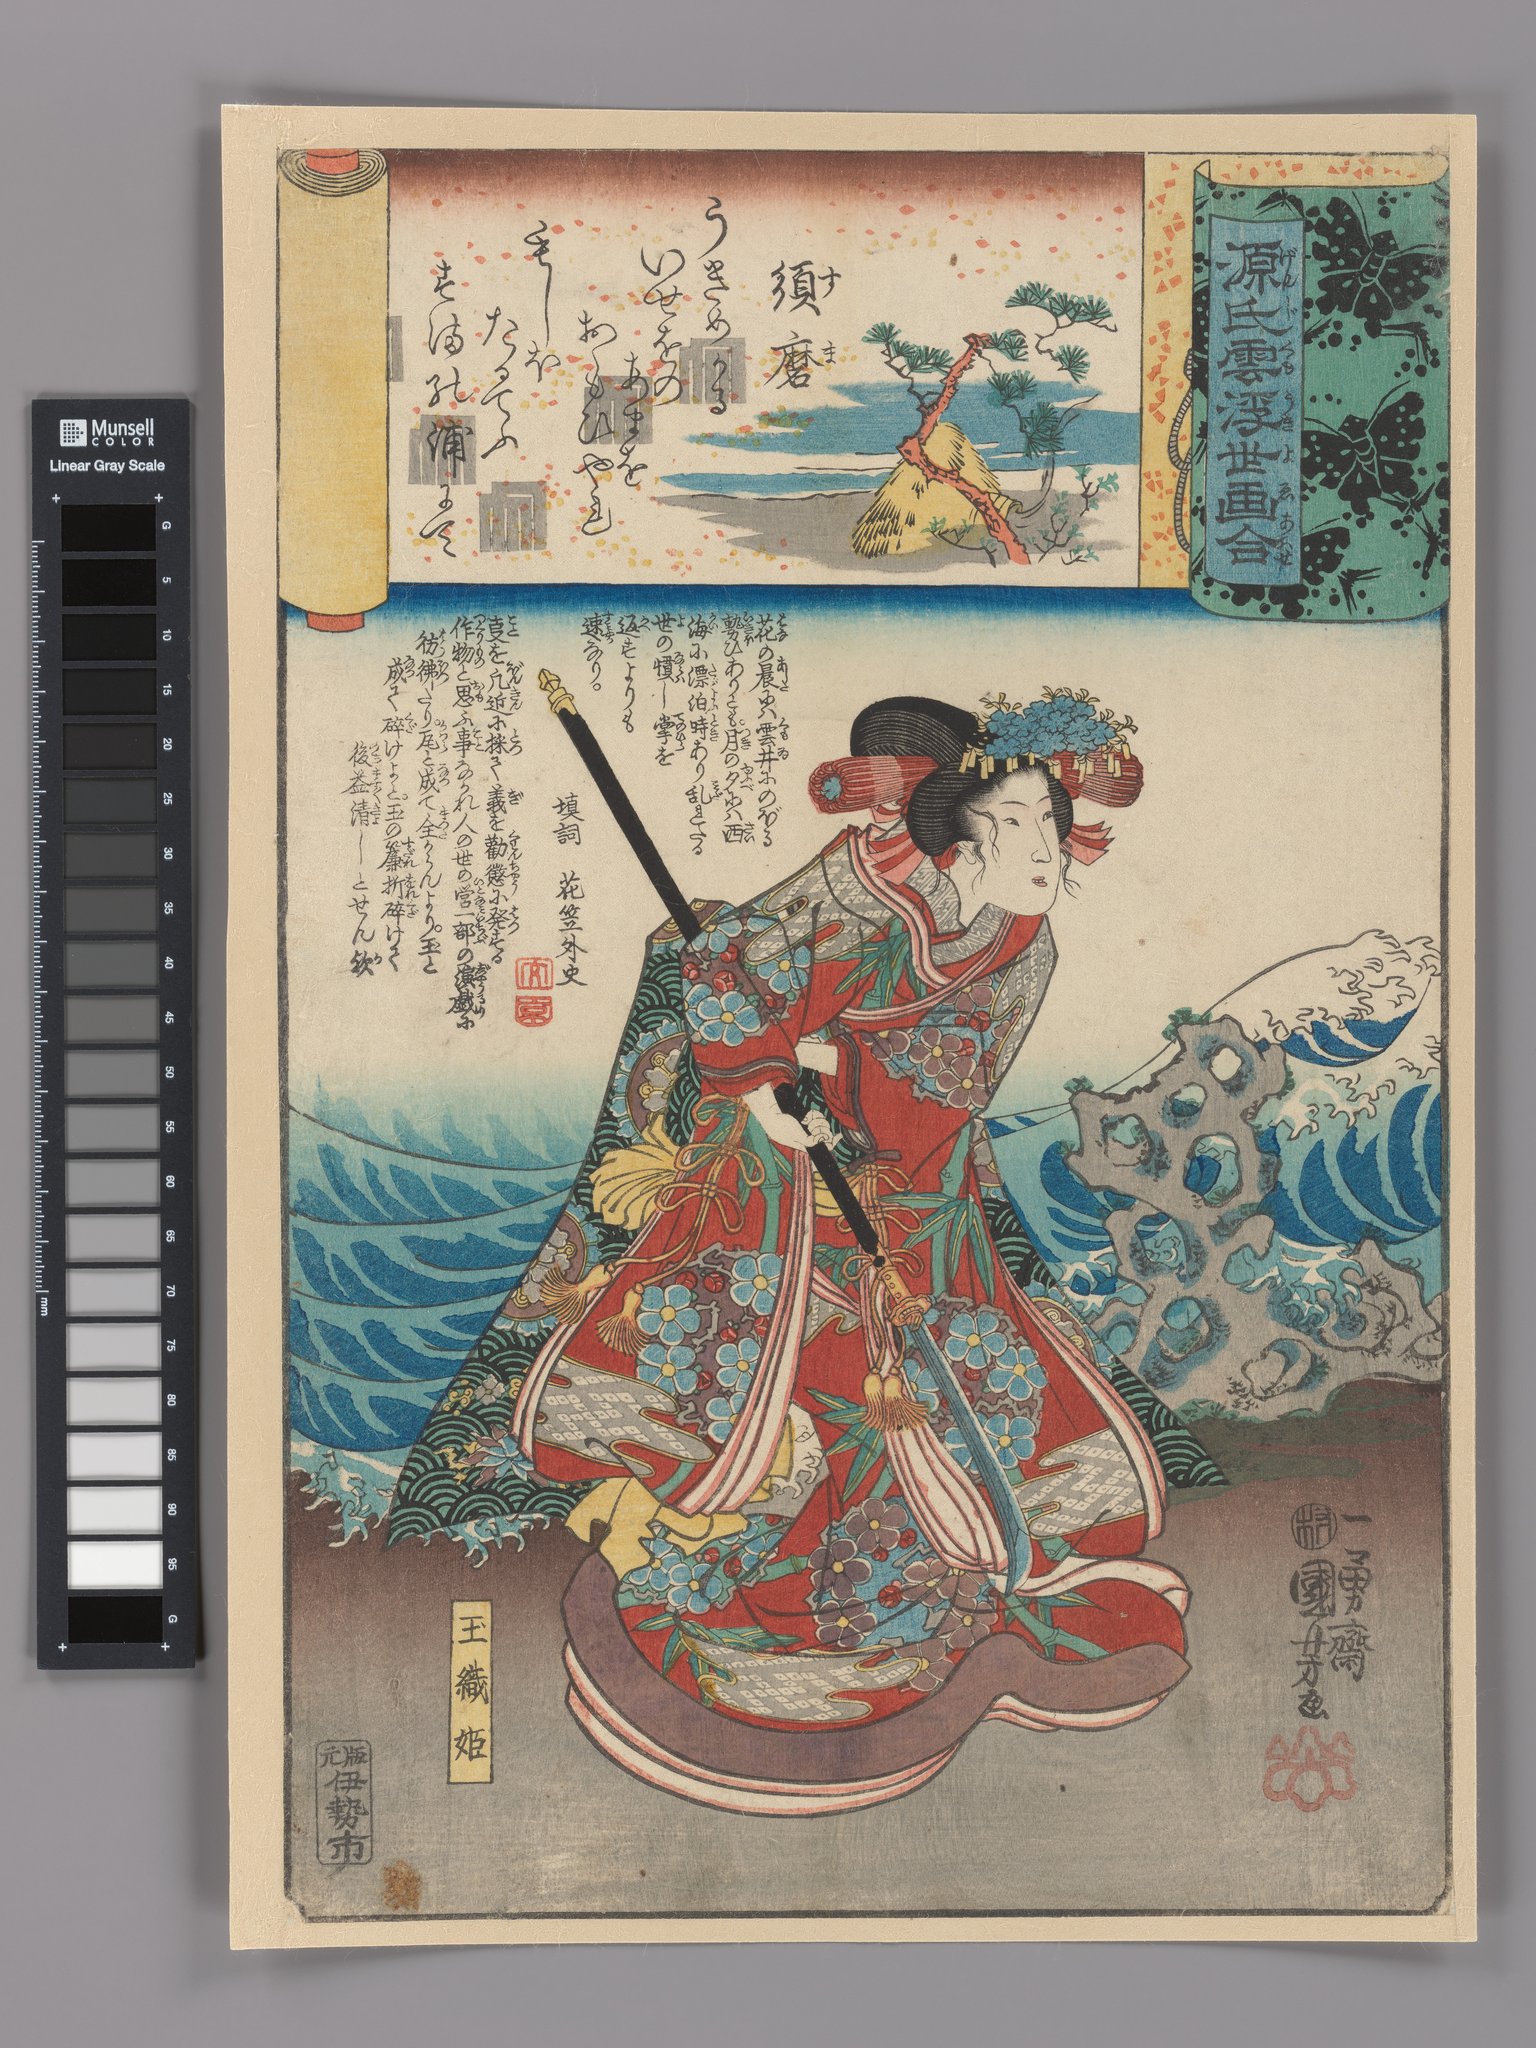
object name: print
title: “‘Exile to Suma’ (Suma): Tamaori-hime,” from the series Scenes amid Genji Clouds Matched with Ukiyo-e Pictures (Genji-gumo ukiyo e-awase)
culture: japanese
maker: utagawa kuniyoshi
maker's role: artist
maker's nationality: japanese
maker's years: 1797-1861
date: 1845-1861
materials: ink, paper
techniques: nishiki e